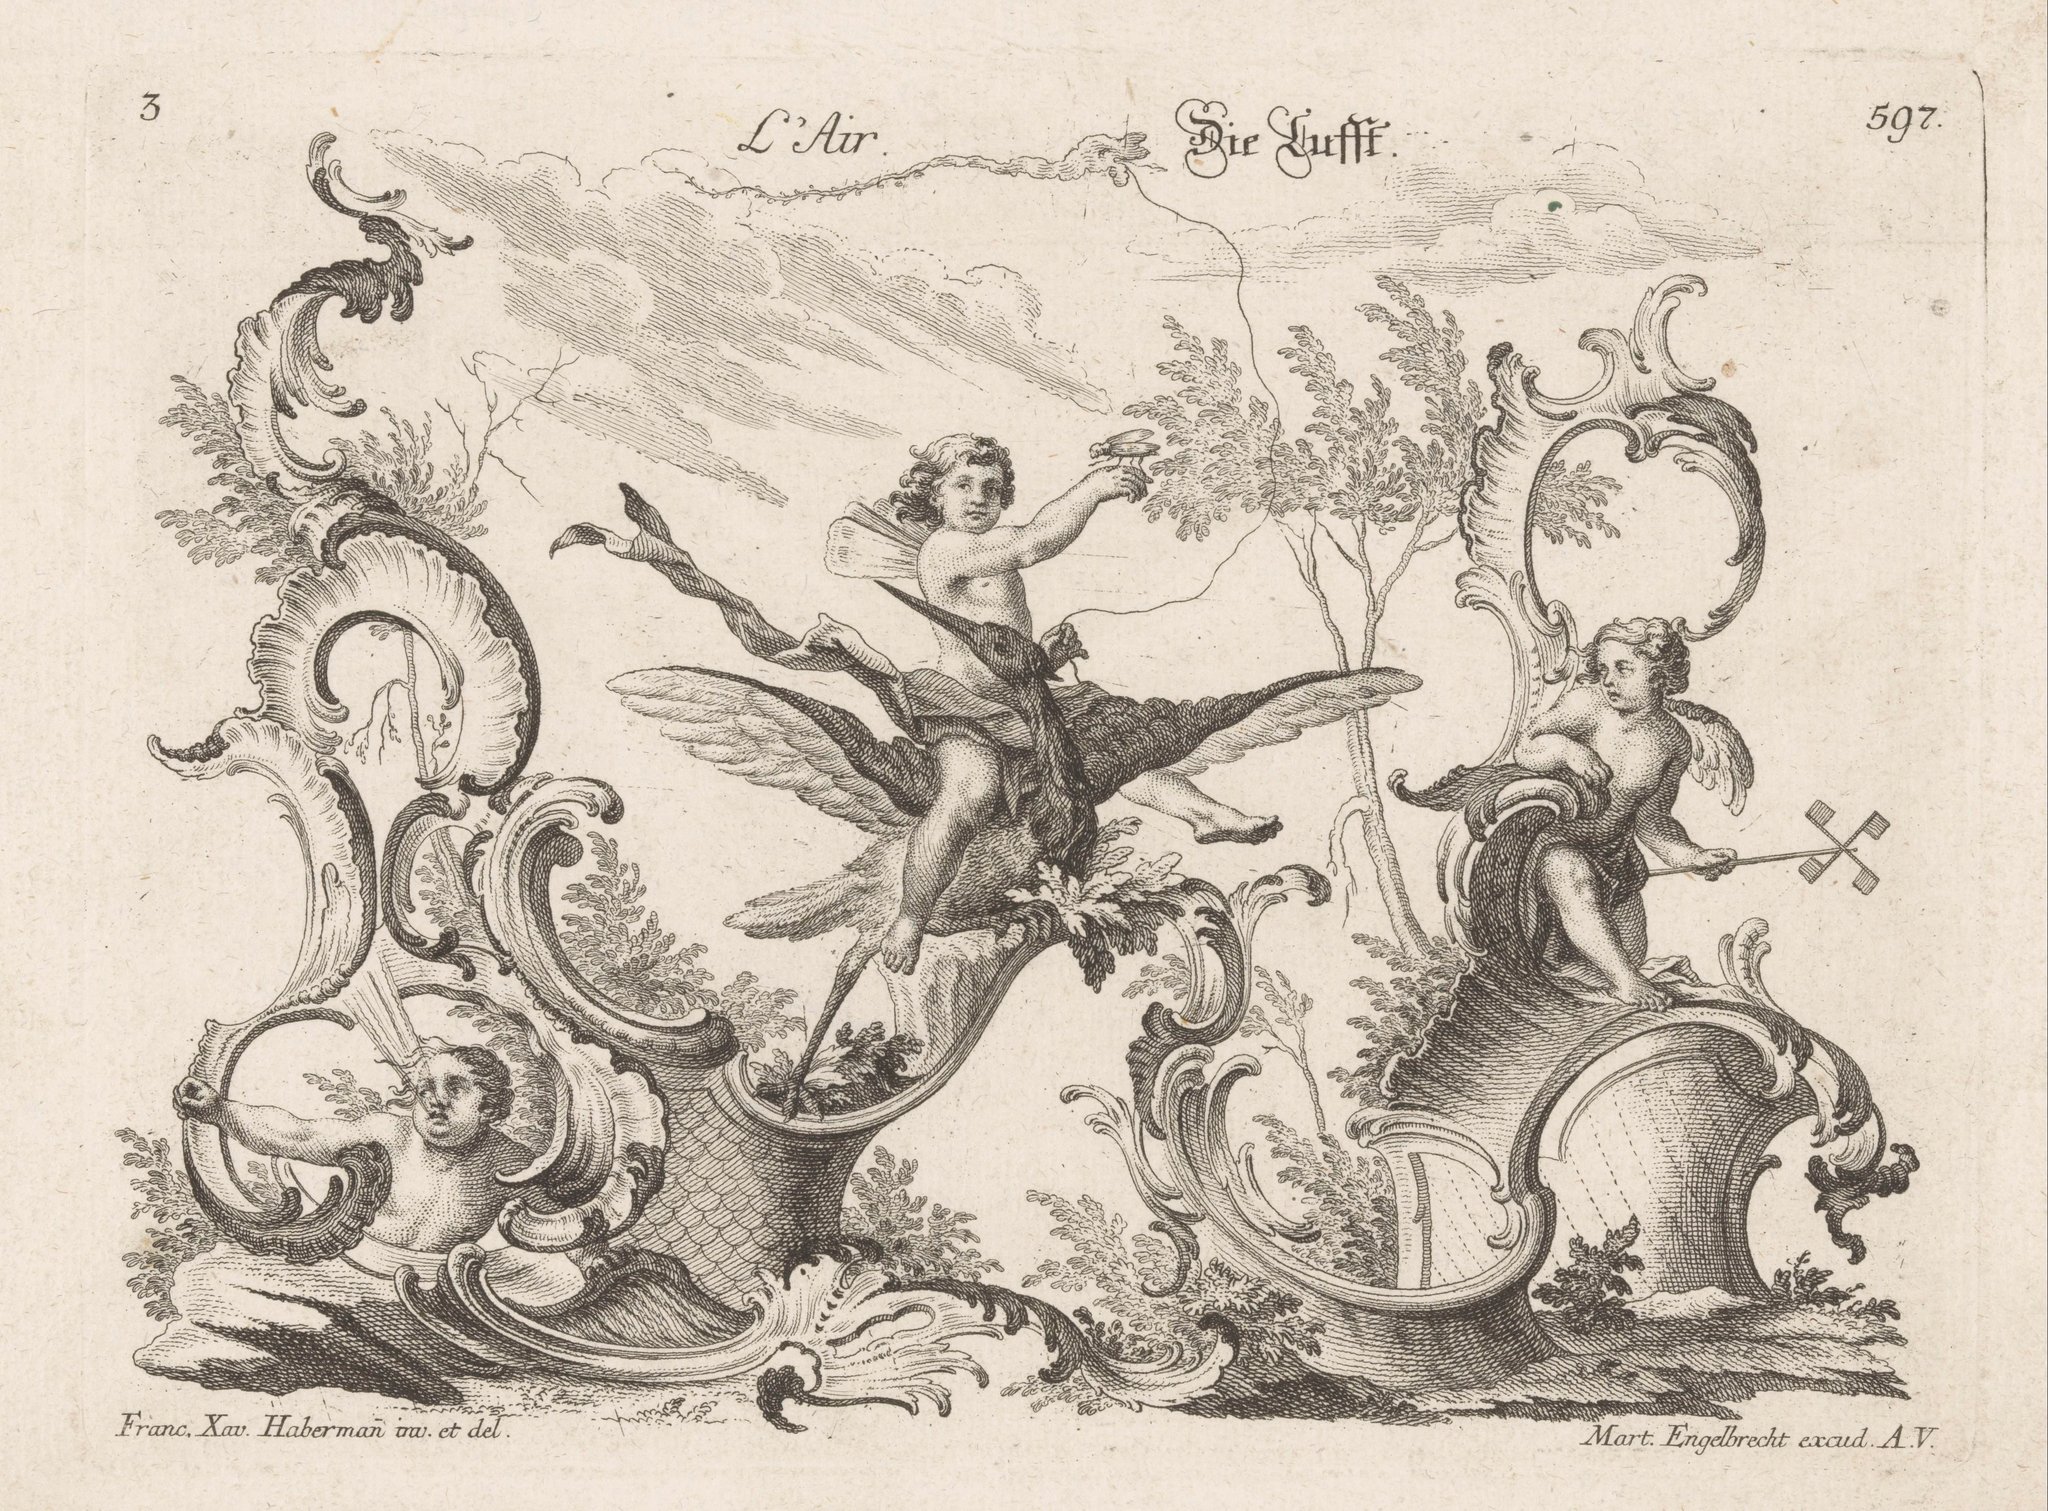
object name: ornament print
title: Vier elementen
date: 1731-1756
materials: paper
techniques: etching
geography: augsburg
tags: air (one of the four elements)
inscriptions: collector's mark: Lugt 2228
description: Allegorie van het element lucht met twee gevleugelde putti met vogel, insect en windmolen. Prentnummer 597.